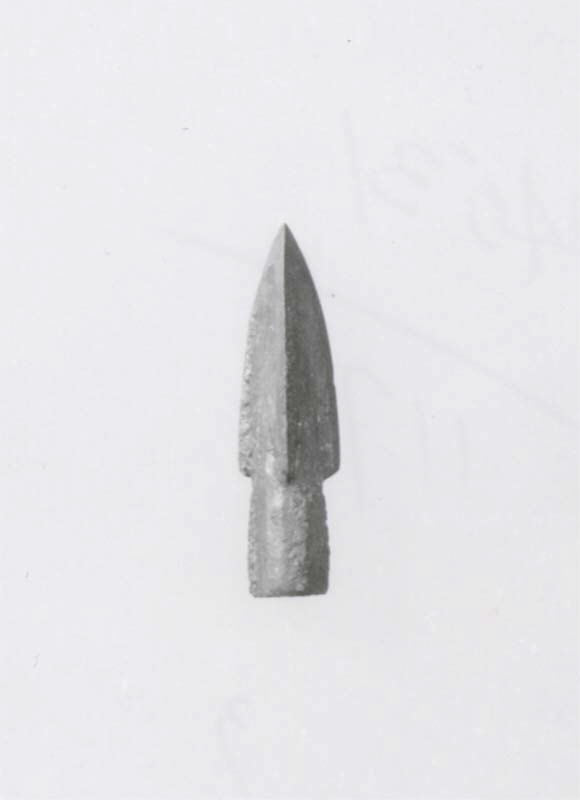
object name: arrowhead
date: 601-700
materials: bronze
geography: iran